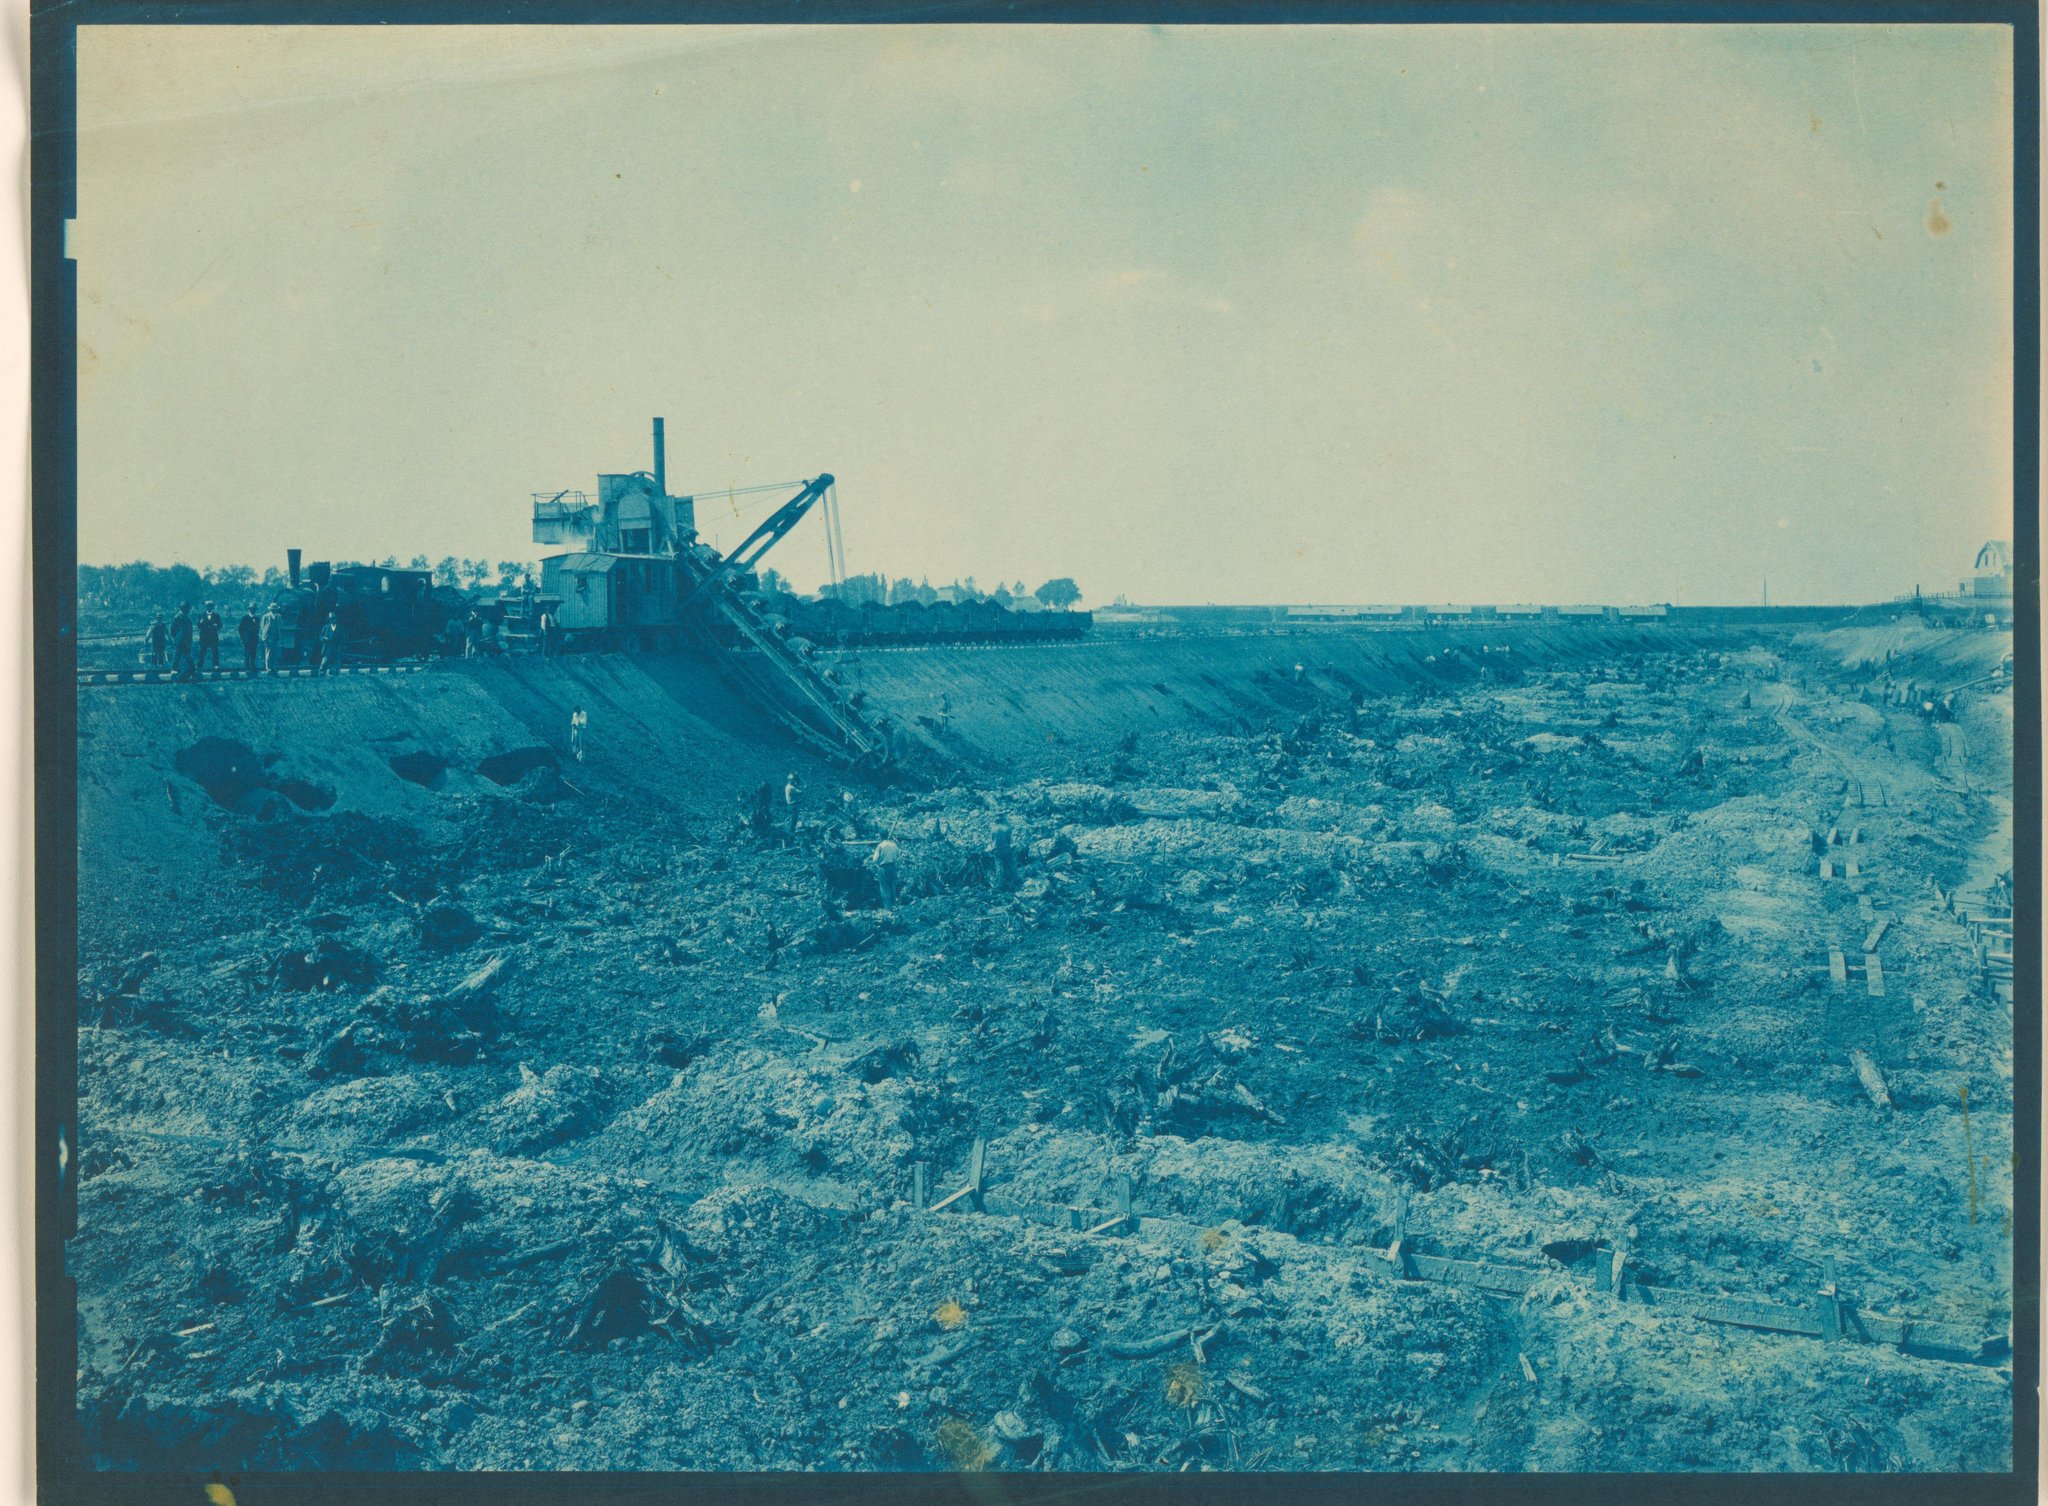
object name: photograph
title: Gezicht op het graven van een funderingsput ten behoeve van de bouw van een schutsluis ten westen van Terneuzen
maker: carl wilhelm bauer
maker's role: fotograaf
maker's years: 1844-1911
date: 1901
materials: photographic support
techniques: cyanotype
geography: terneuzen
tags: digging (industrial process)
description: Gebaseerd op opschrift op exemplaar (gedrukt als ontwikkelgelatinezilverdruk) in collectie Nationaal Archief, Den Haag (coll. Rijkswaterstaat, inv.nr. 873): Schutsluis bewesten Terneuzen / Fundeeringput / De uitgraving geschiedt ongeveer ter halver diepte of 4,50 M beneden het maaiveld // Gezien van de zuidzijde / 20 Juli 1901.